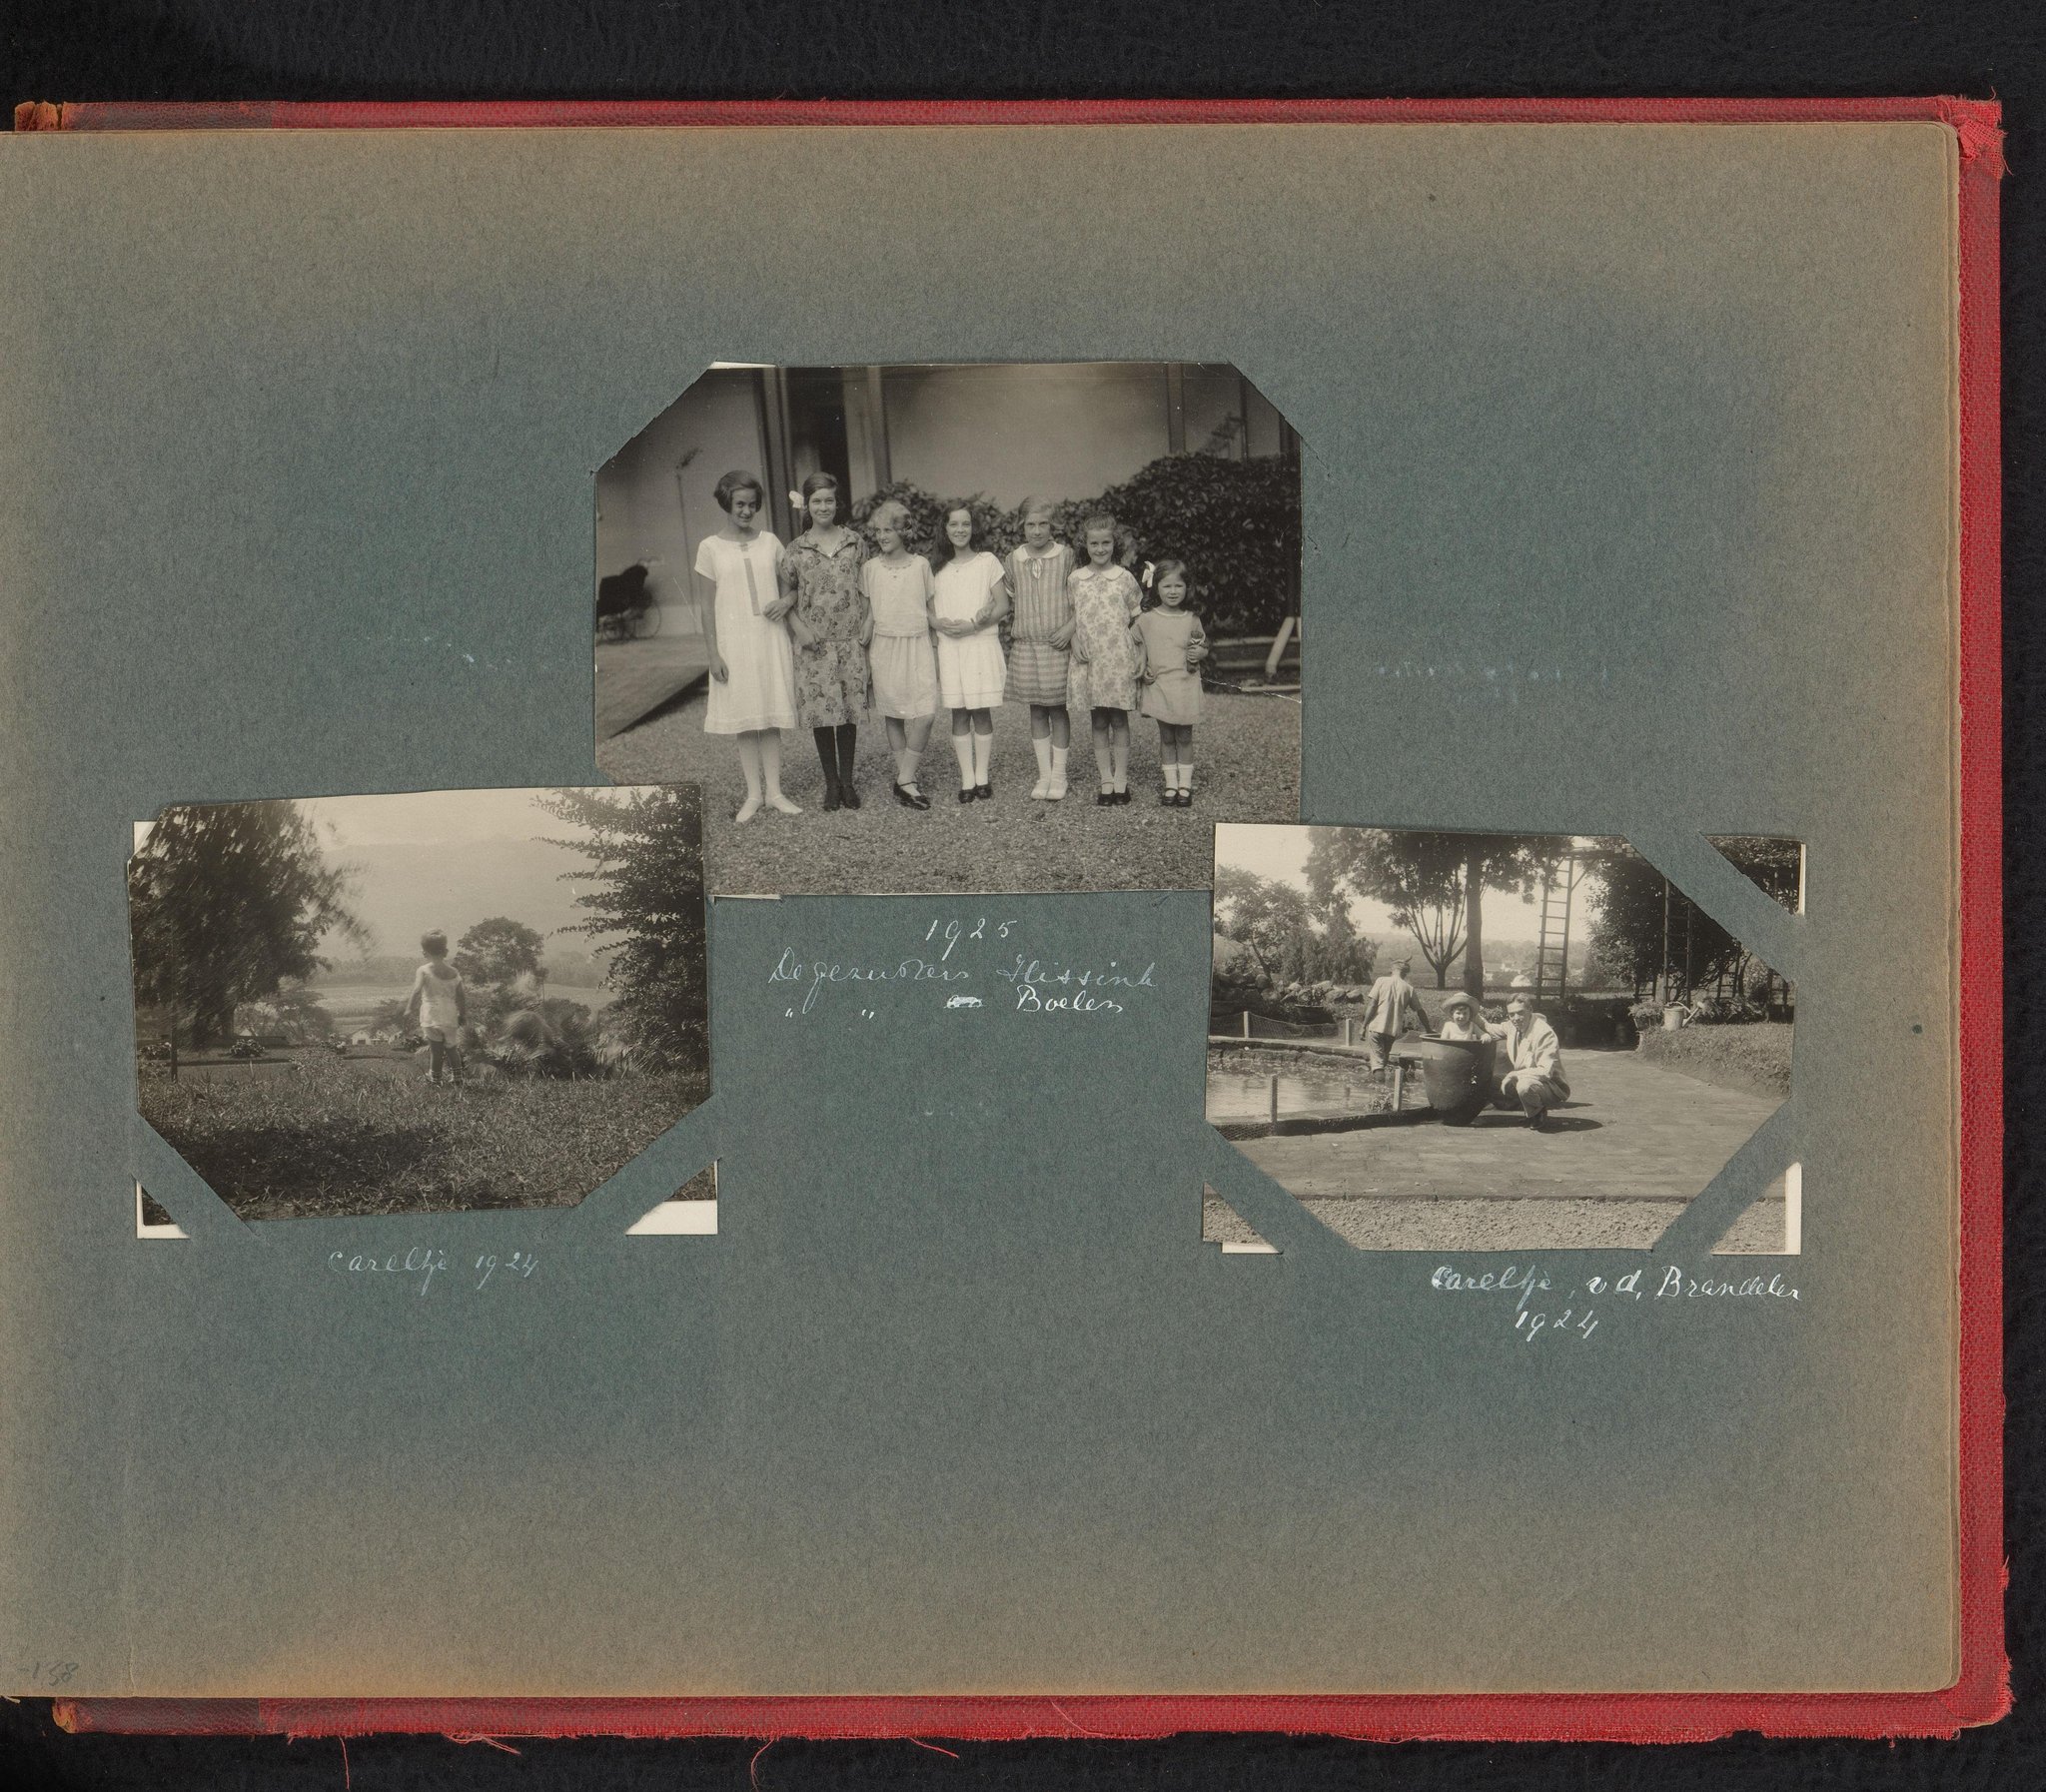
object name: album leaf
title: Carel Matthes in Indonesië en een groepsportret van de zussen Hissink met Eva en Hetty Boelen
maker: charlotte alida boelen-matthes (lot)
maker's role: amateurfotograaf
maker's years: 1889-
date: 1924-1925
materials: paper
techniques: gelatin silver print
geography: indonesia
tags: eva charlotte pennink-boelen, family life, indonesia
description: Groot Plattenberg was eigendom van Jacob Theodorus (Co) Boelen.